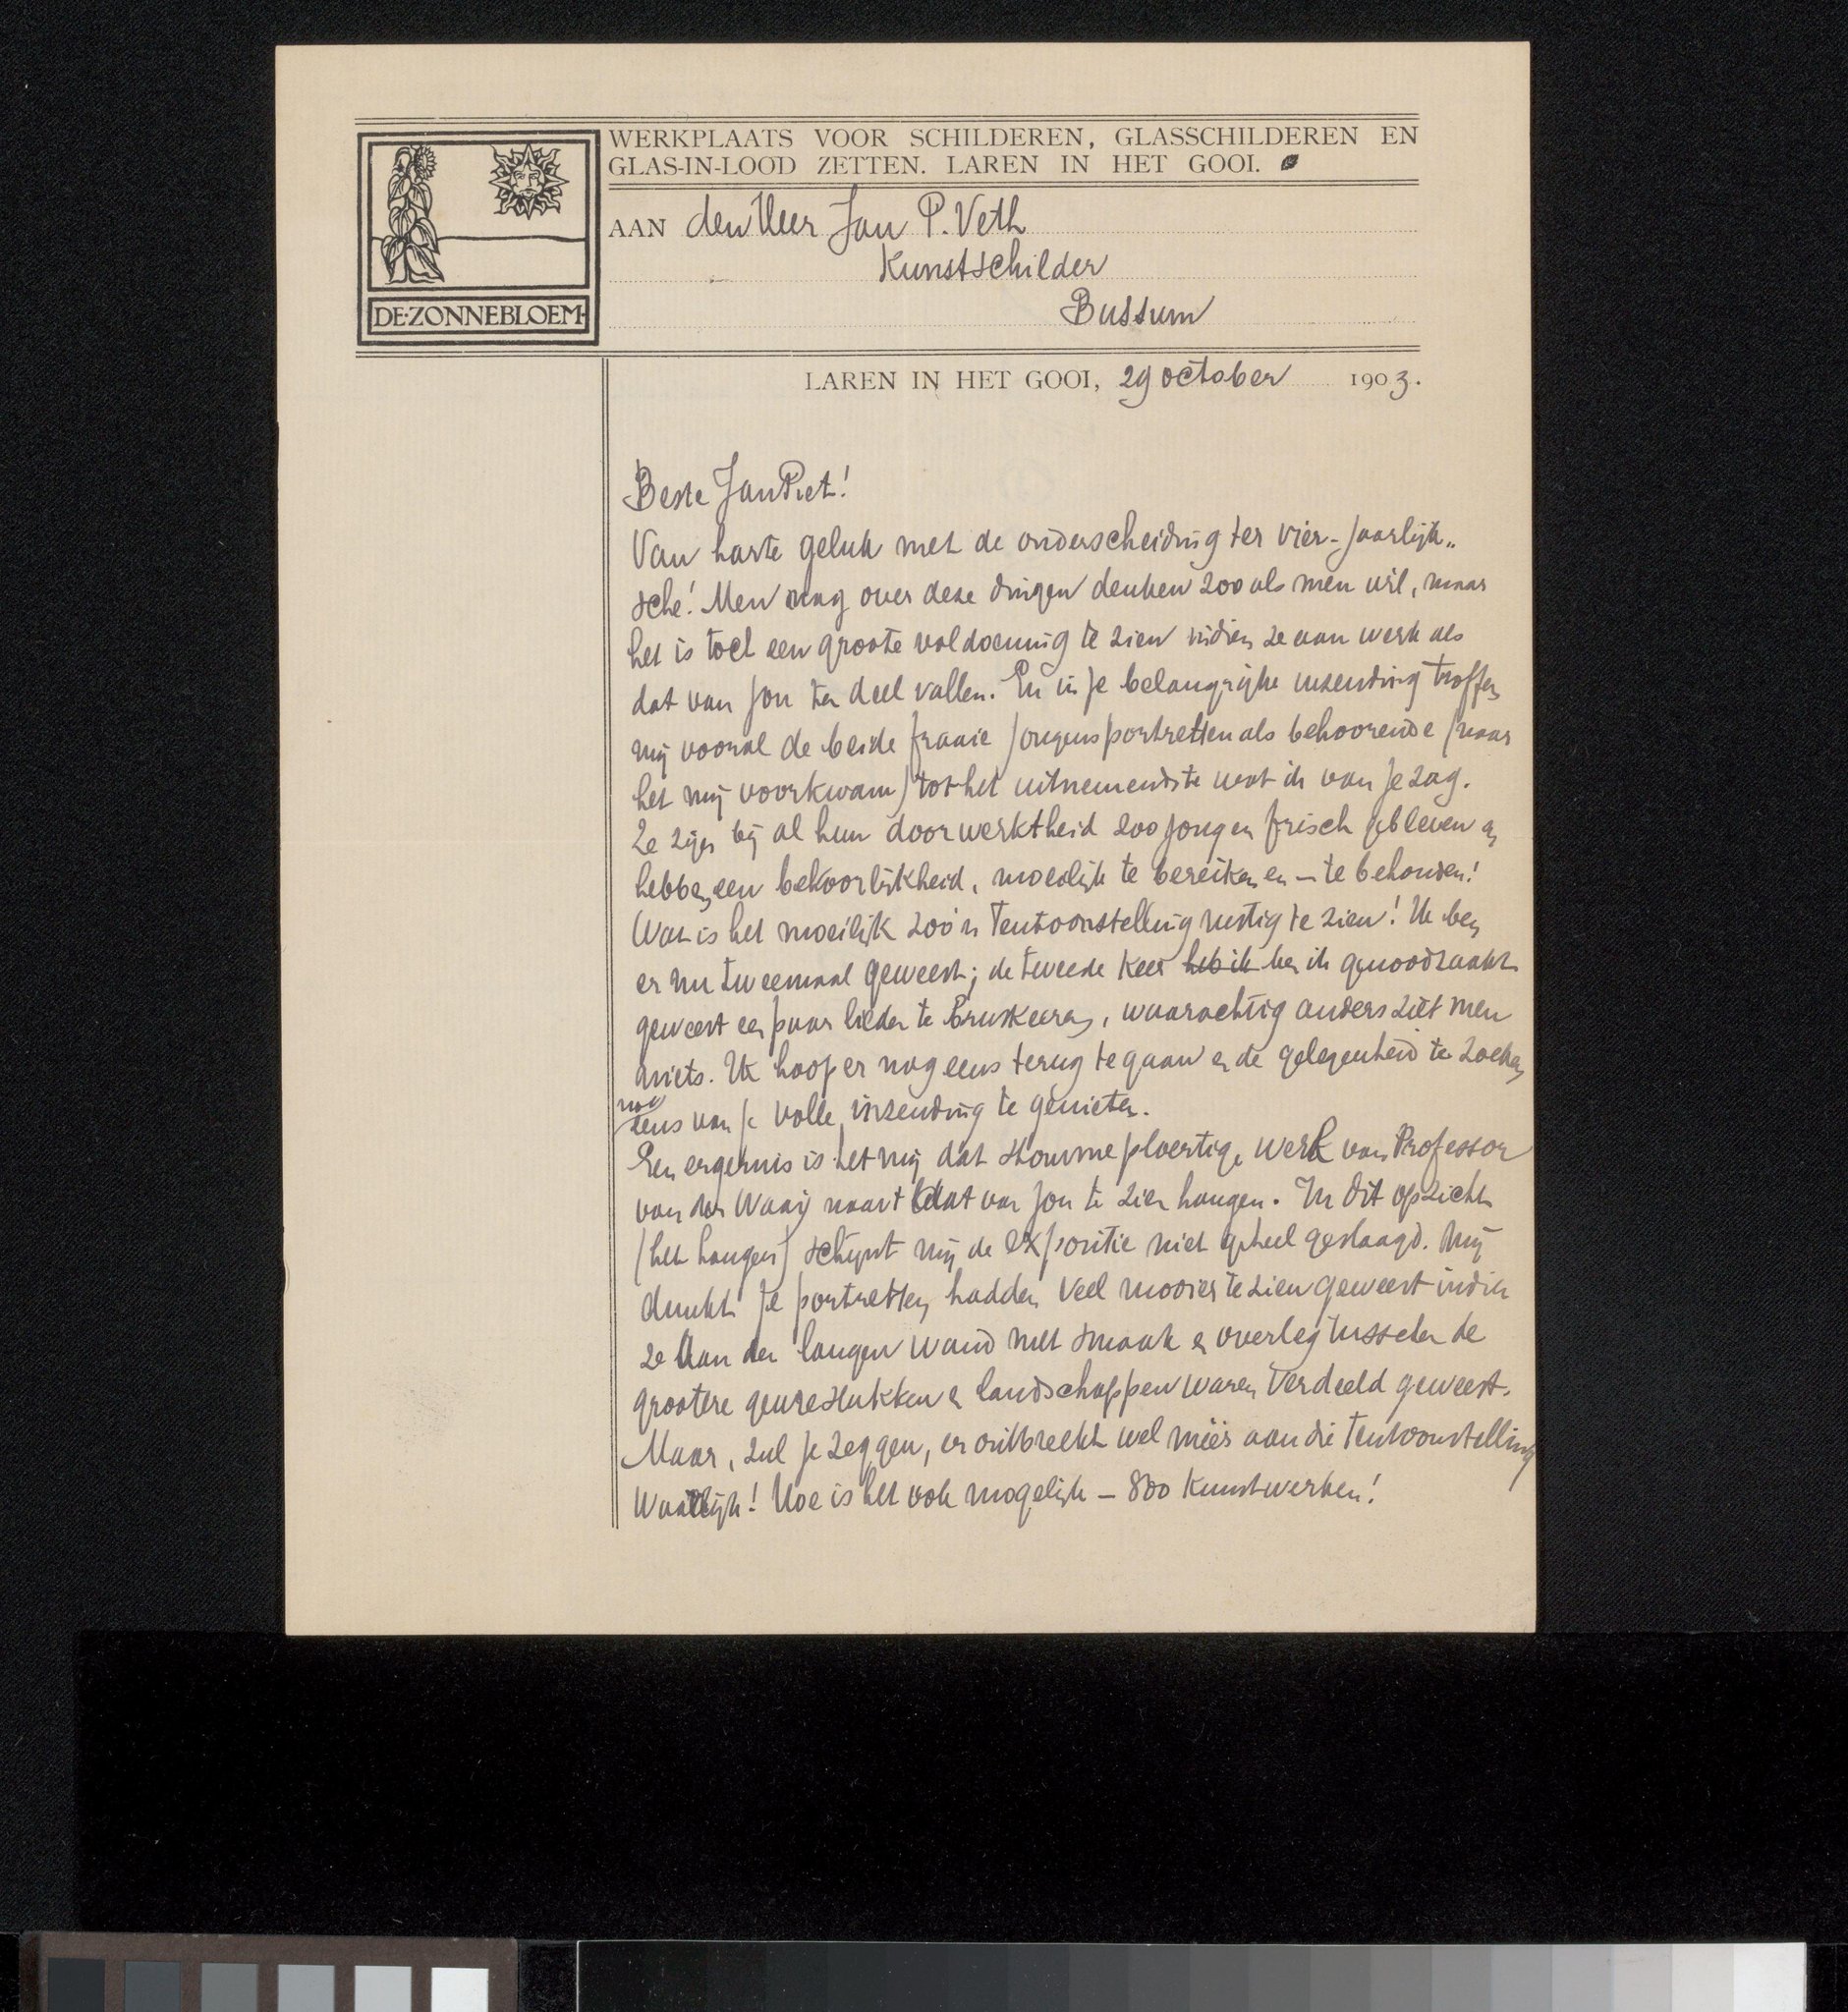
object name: letter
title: Brief aan Jan Veth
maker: antoon derkinderen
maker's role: draughtsman, painter, print maker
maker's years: 1859-1925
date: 1903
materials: ink, paper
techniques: pen, printing, writing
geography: laren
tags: dordrecht, designer, jan veth, amsterdam, painter, print maker, draughtsman, nicolaas van der waay, berlin, peter von cornelius, the monumental arts, anonymous historical person portrayed, painting (including book-illumination, miniature-painting), exhibition ~ art, germany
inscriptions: collector's mark: ‘RPK’